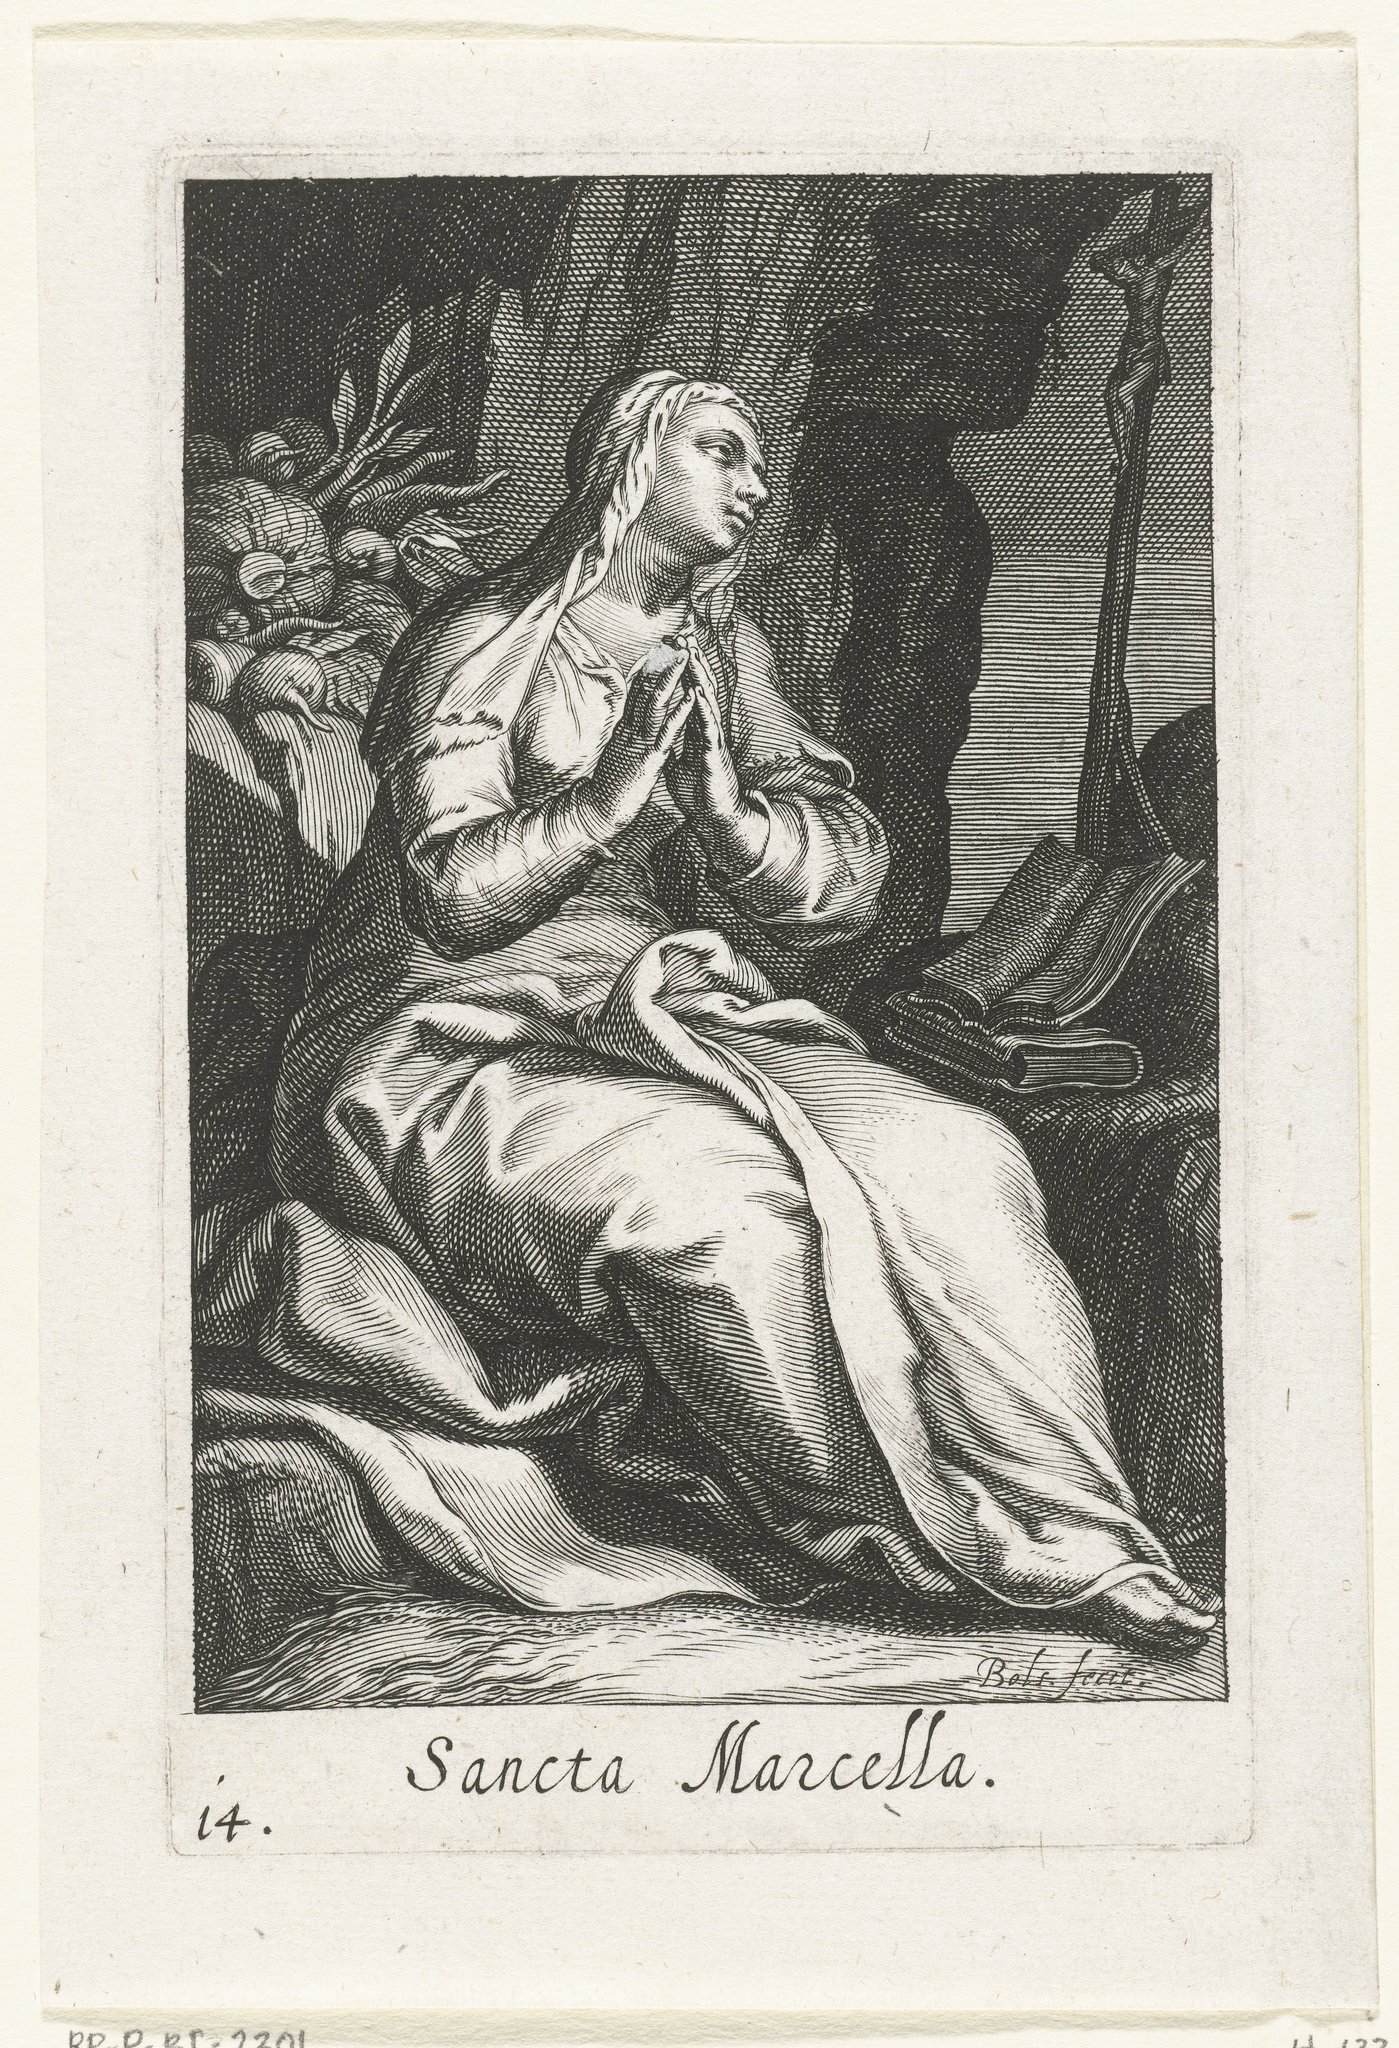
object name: print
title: Sancta Marcella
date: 1590-1612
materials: paper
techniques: engraving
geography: amsterdam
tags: anchorite, hermit, female saints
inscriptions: collector's mark: Lugt 2228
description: Prent uit: Sacra Eremus Ascetriarum, uitgever Boëtius Adamsz. Bolswert, 1612 of Hendrik Aertssen, Antwerpen 1619. Prent uit de serie van vijfentwintig kluizenaressen in deze uitgaven. In 1612 verscheen een ongebonden editie maar op basis van de gewijzigde opschriften en samenstelling van de serie kluizenaars wordt aangenomen dat de prenten van de uitgave 1619 ook in 1612 of iets daarvoor gedrukt werden. De serie kluizenaressen bleef vrijwel ongewijzigd in de ongebonden uitgave van 1612, dit compliceert de datering van de losse bladen in de collectie van het RMA, zie Roethlisberger 1993, p. 171-175.